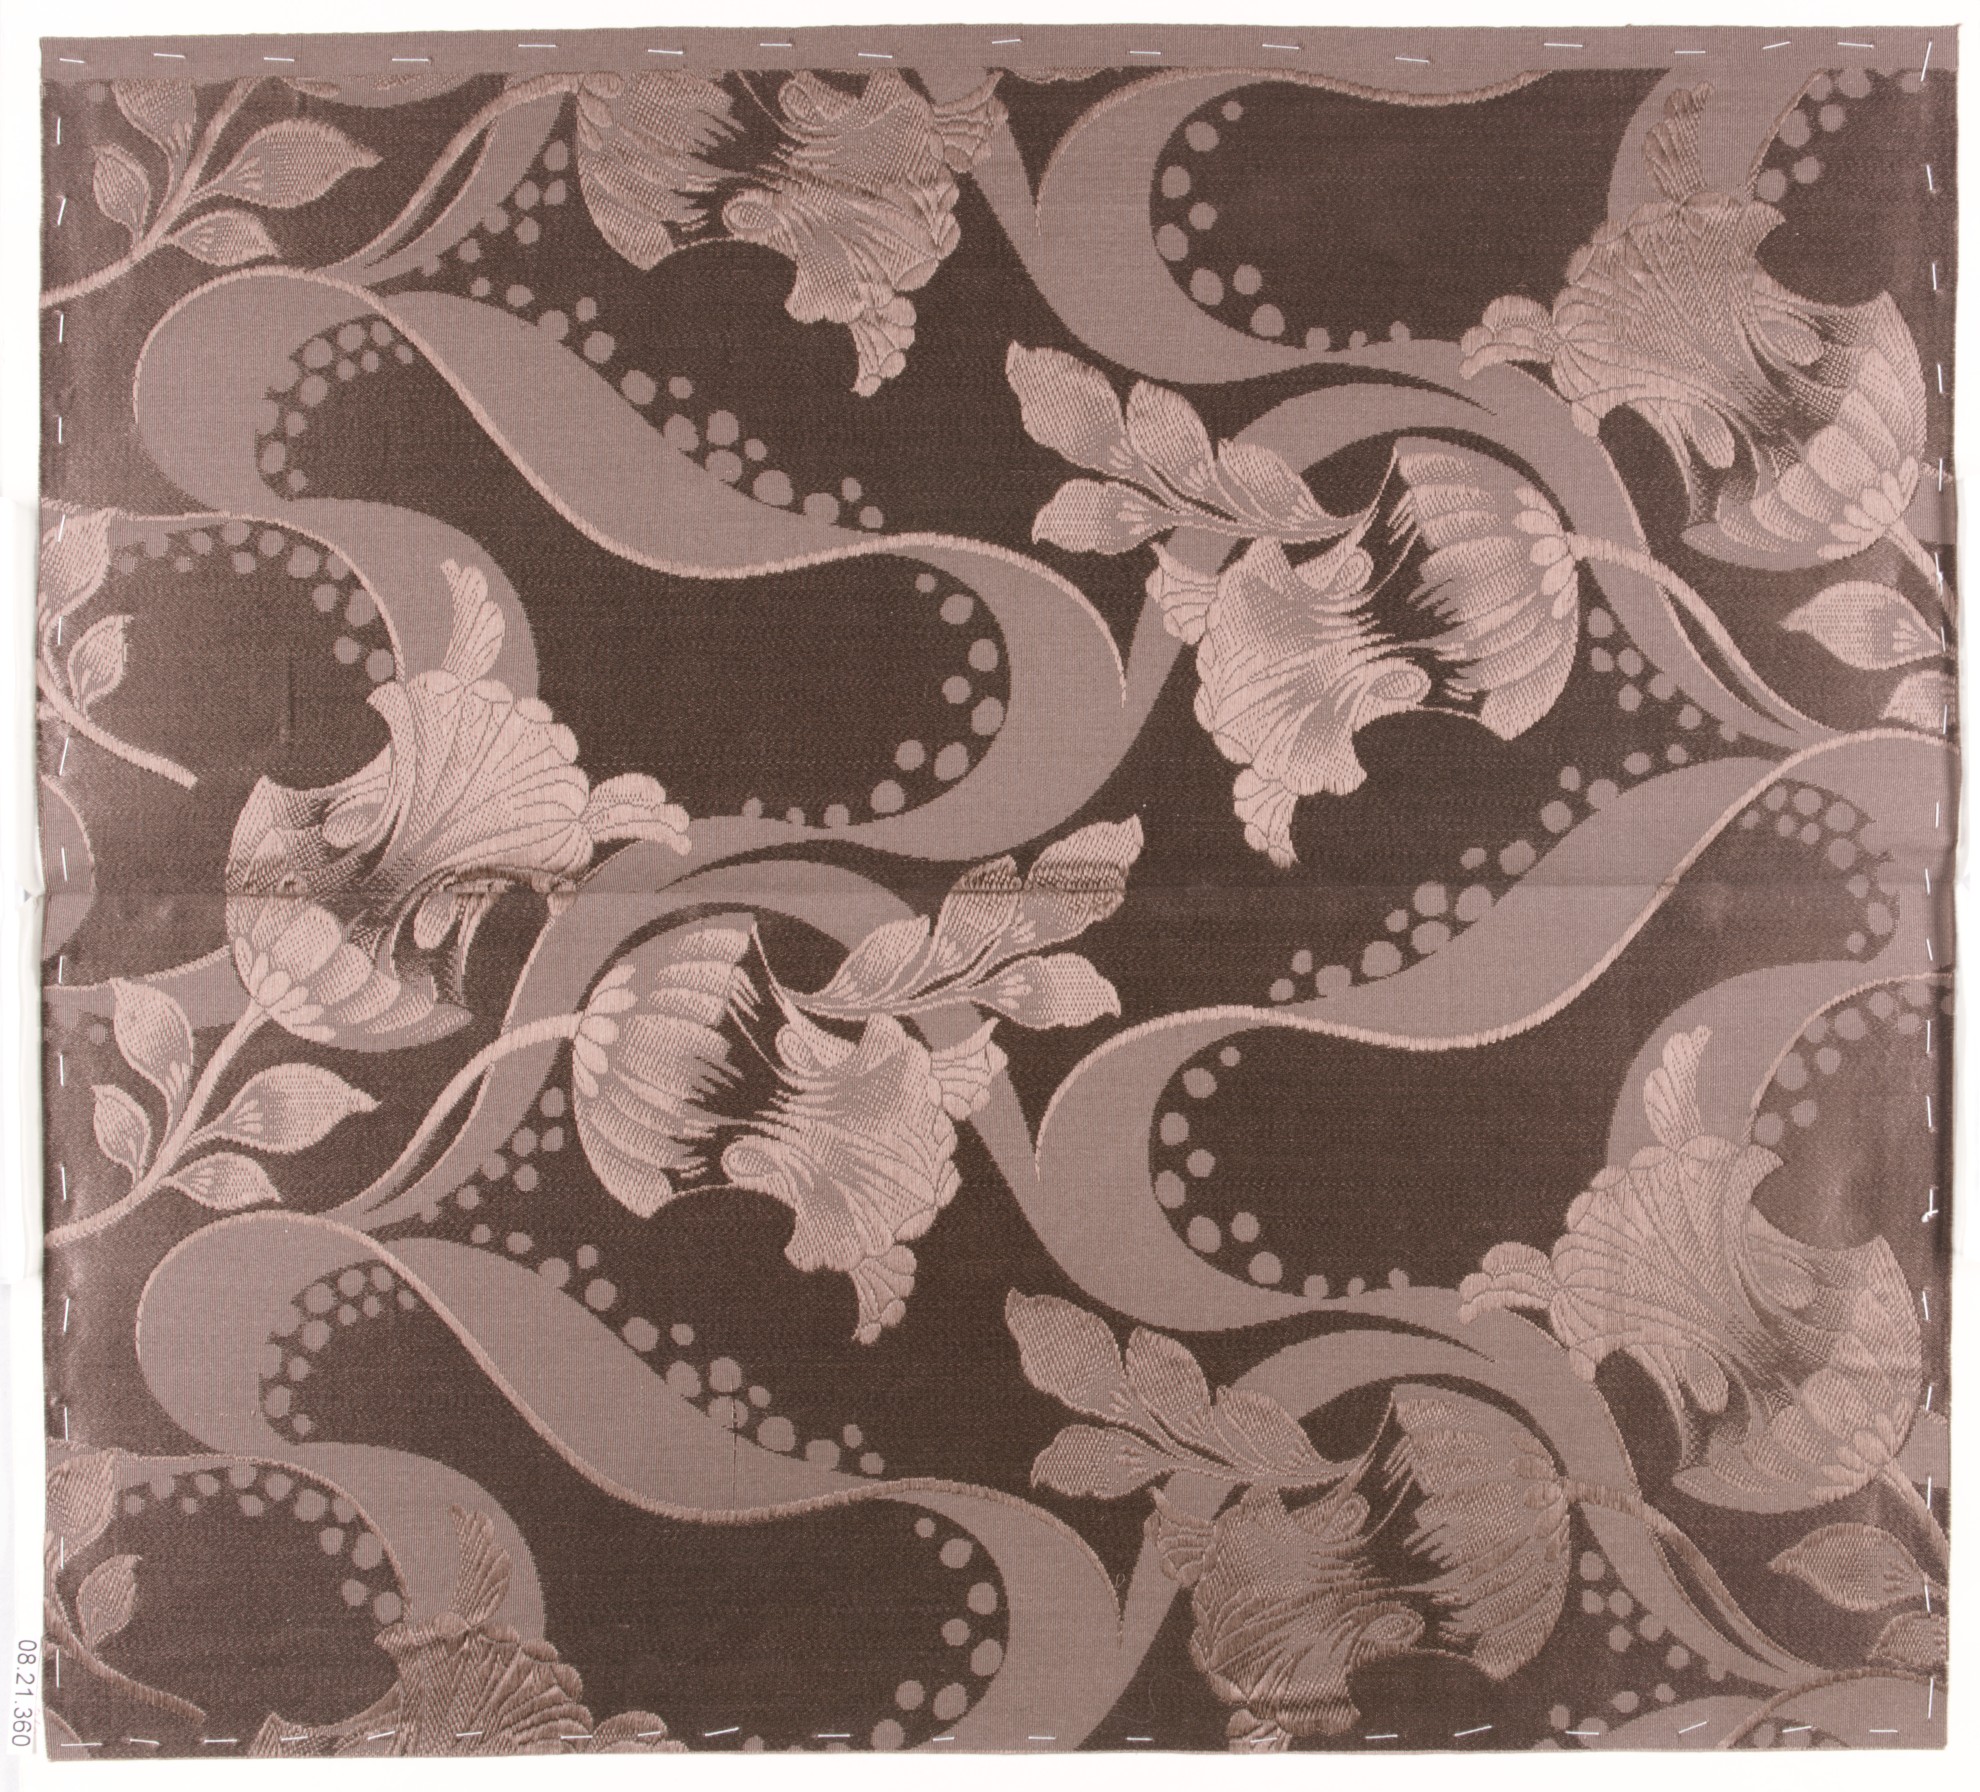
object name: textile sample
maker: Anonymous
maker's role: designer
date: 1900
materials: silk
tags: flowers